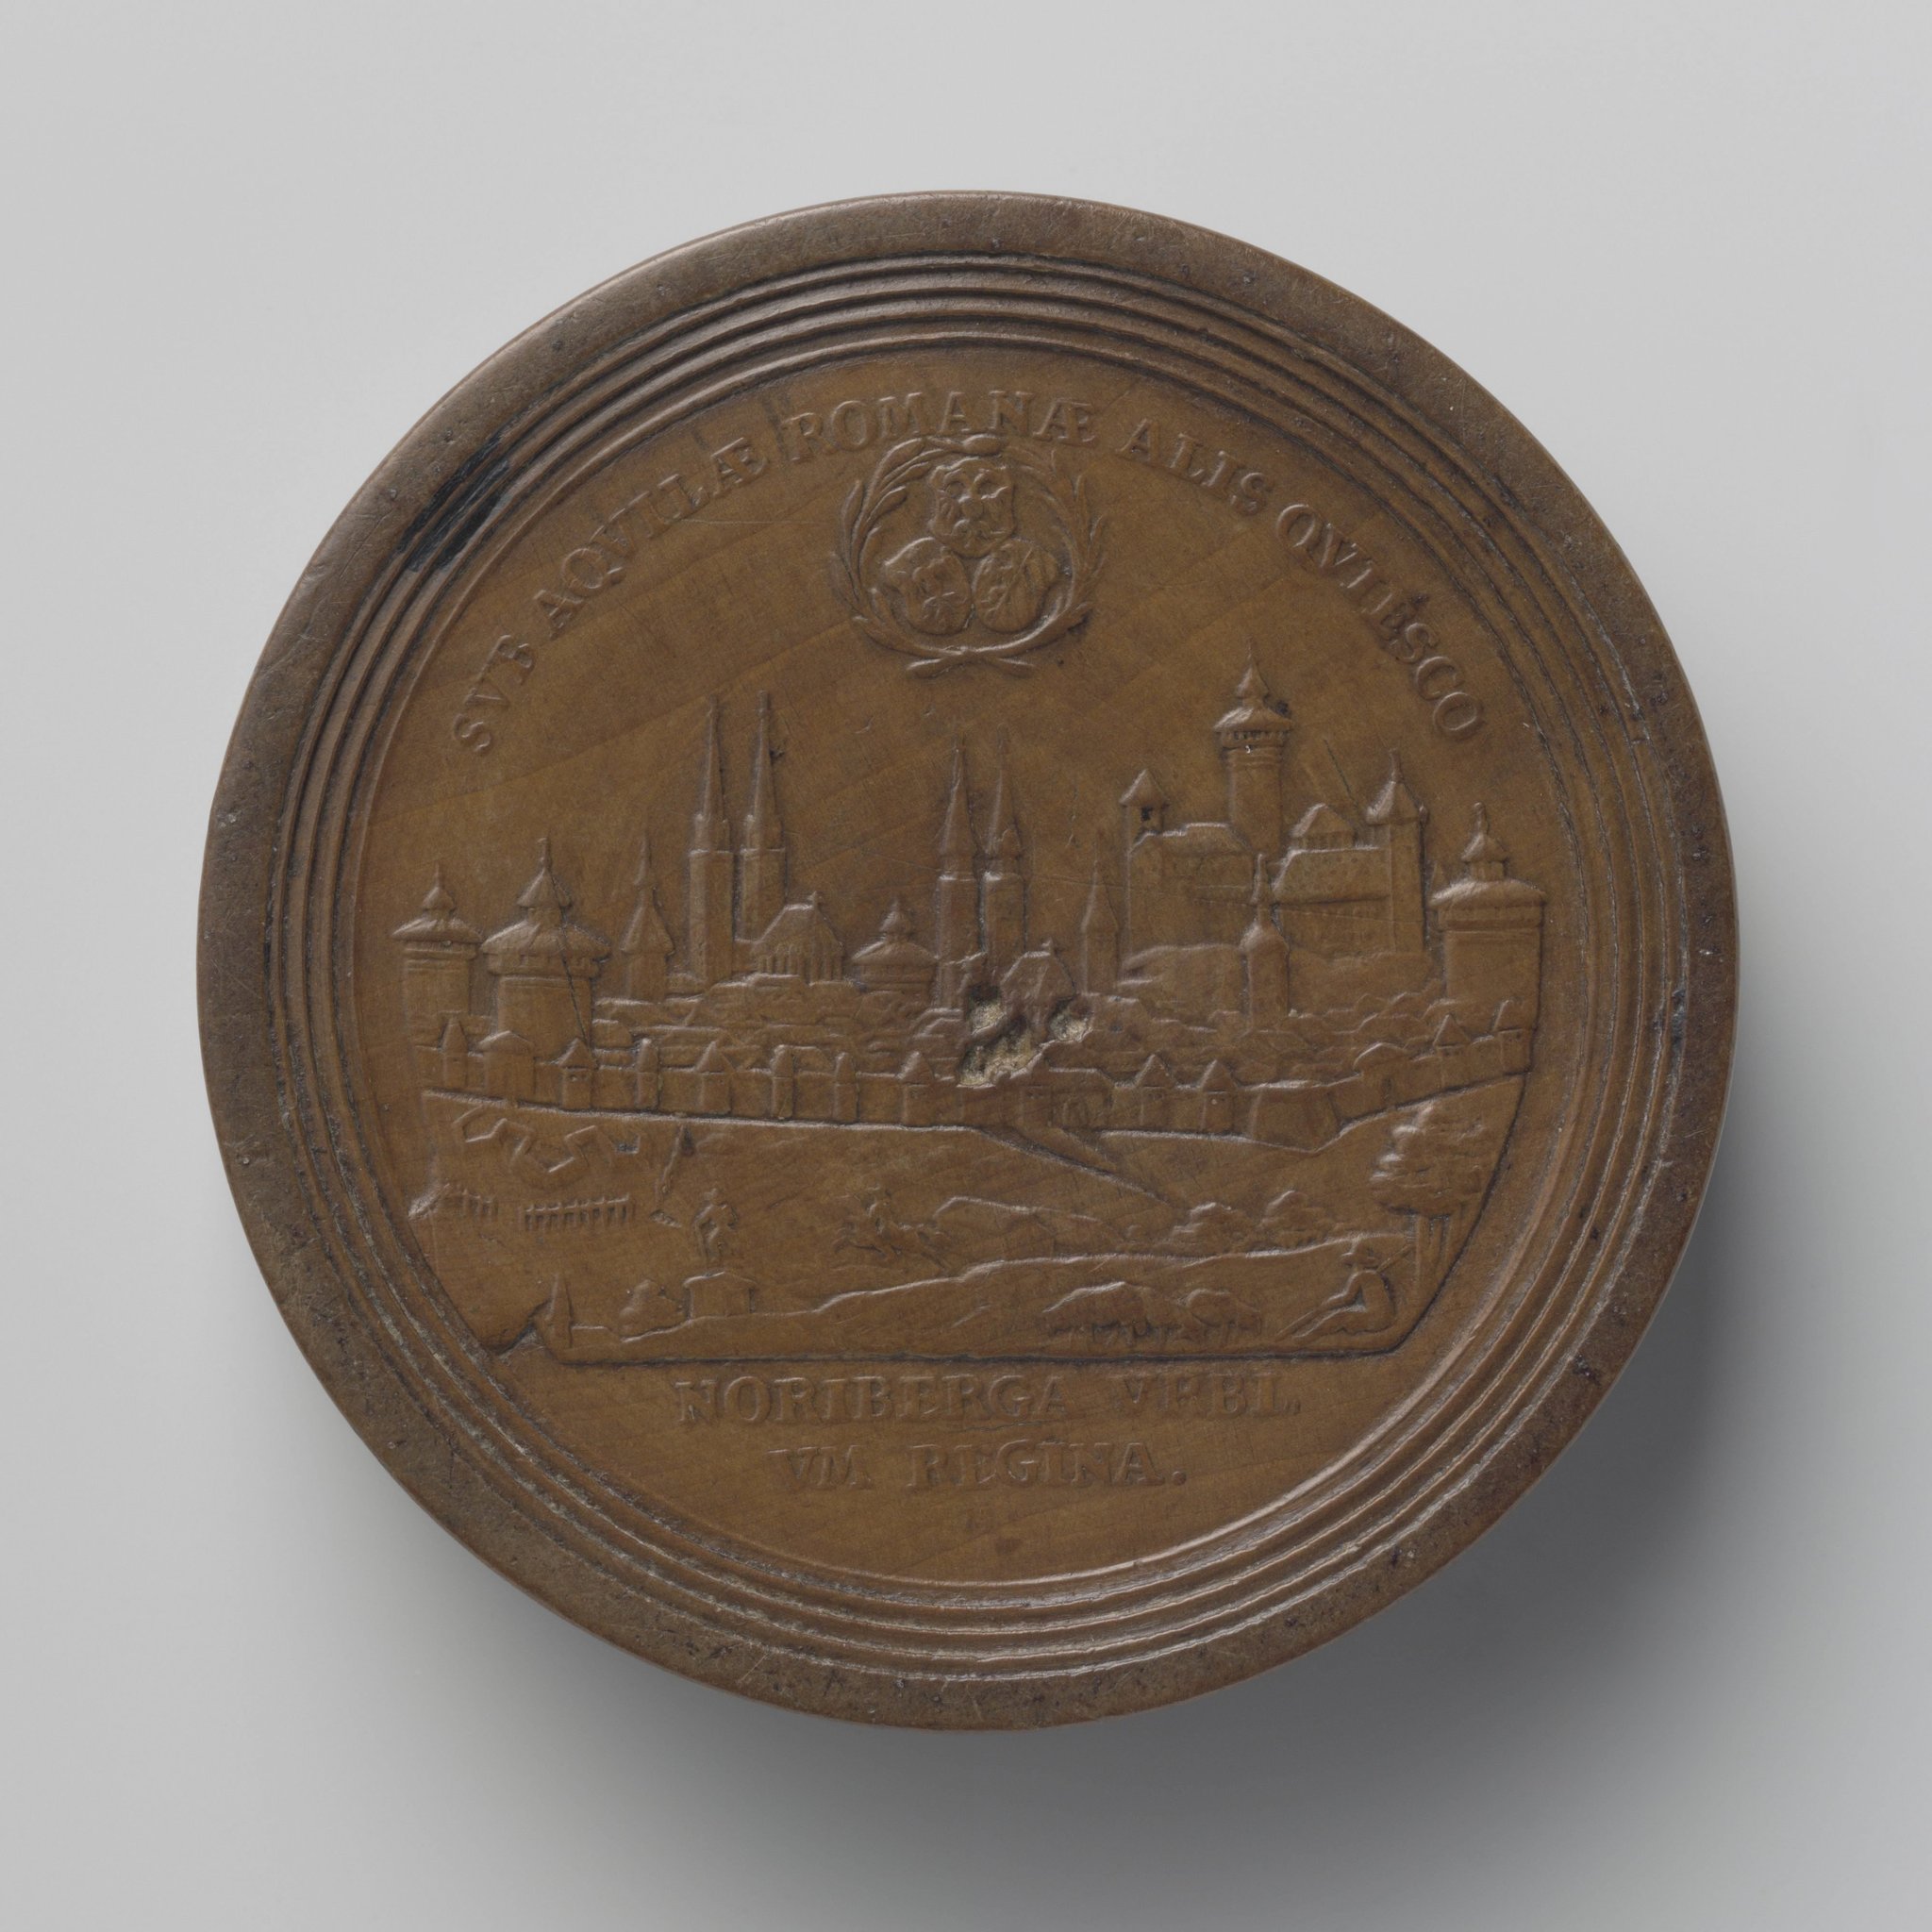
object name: sculpture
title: Damschijf met gezicht op Neurenberg en portretten van Jozef I van Oostenrijk en zeven keurvorsten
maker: Anonymous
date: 1690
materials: wood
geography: nuremberg